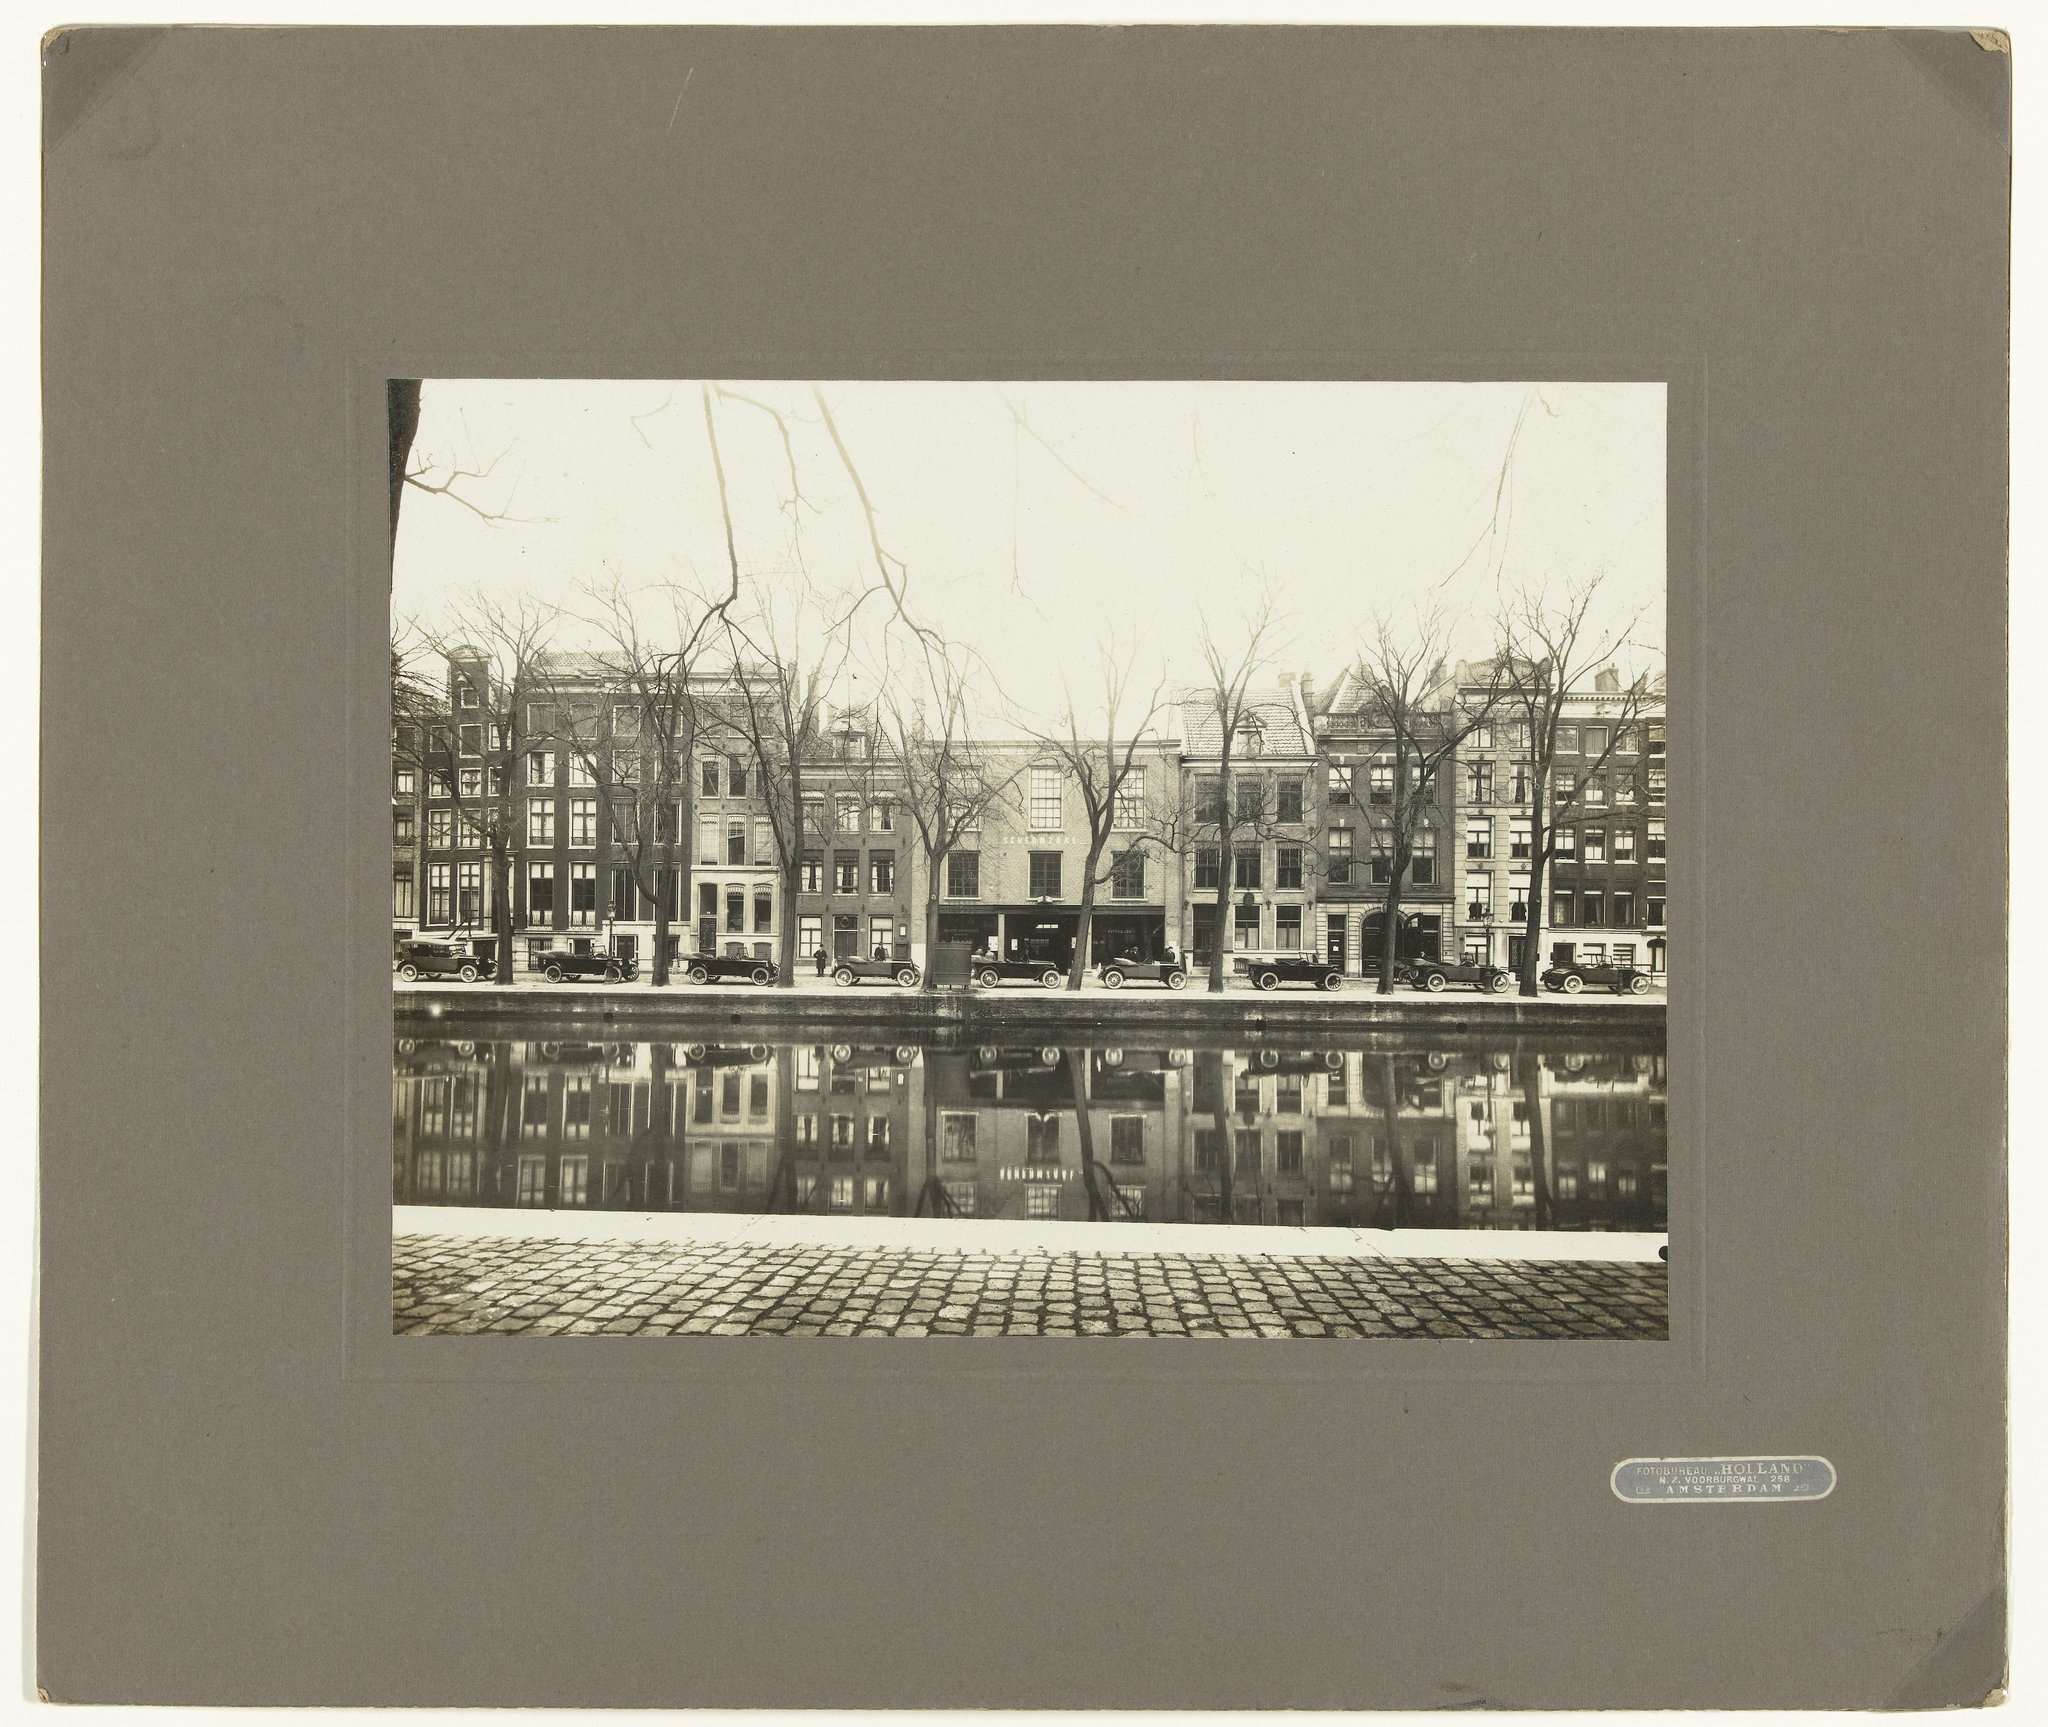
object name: photograph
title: Geparkeerde auto's voor een automobielhandel op een gracht in Amsterdam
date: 1914-1924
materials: paper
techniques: gelatin silver print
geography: amsterdam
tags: automobile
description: De autohandel van Dirk van der Mark aan de Keizersgracht 635 te Amsterdam. Het filiaal opende op 6 december 1913. Voor het pand staat een rij Amerikaanse Hupmobiles. Boven de autohandel was Schermzaal Giandomenici gevestigd.